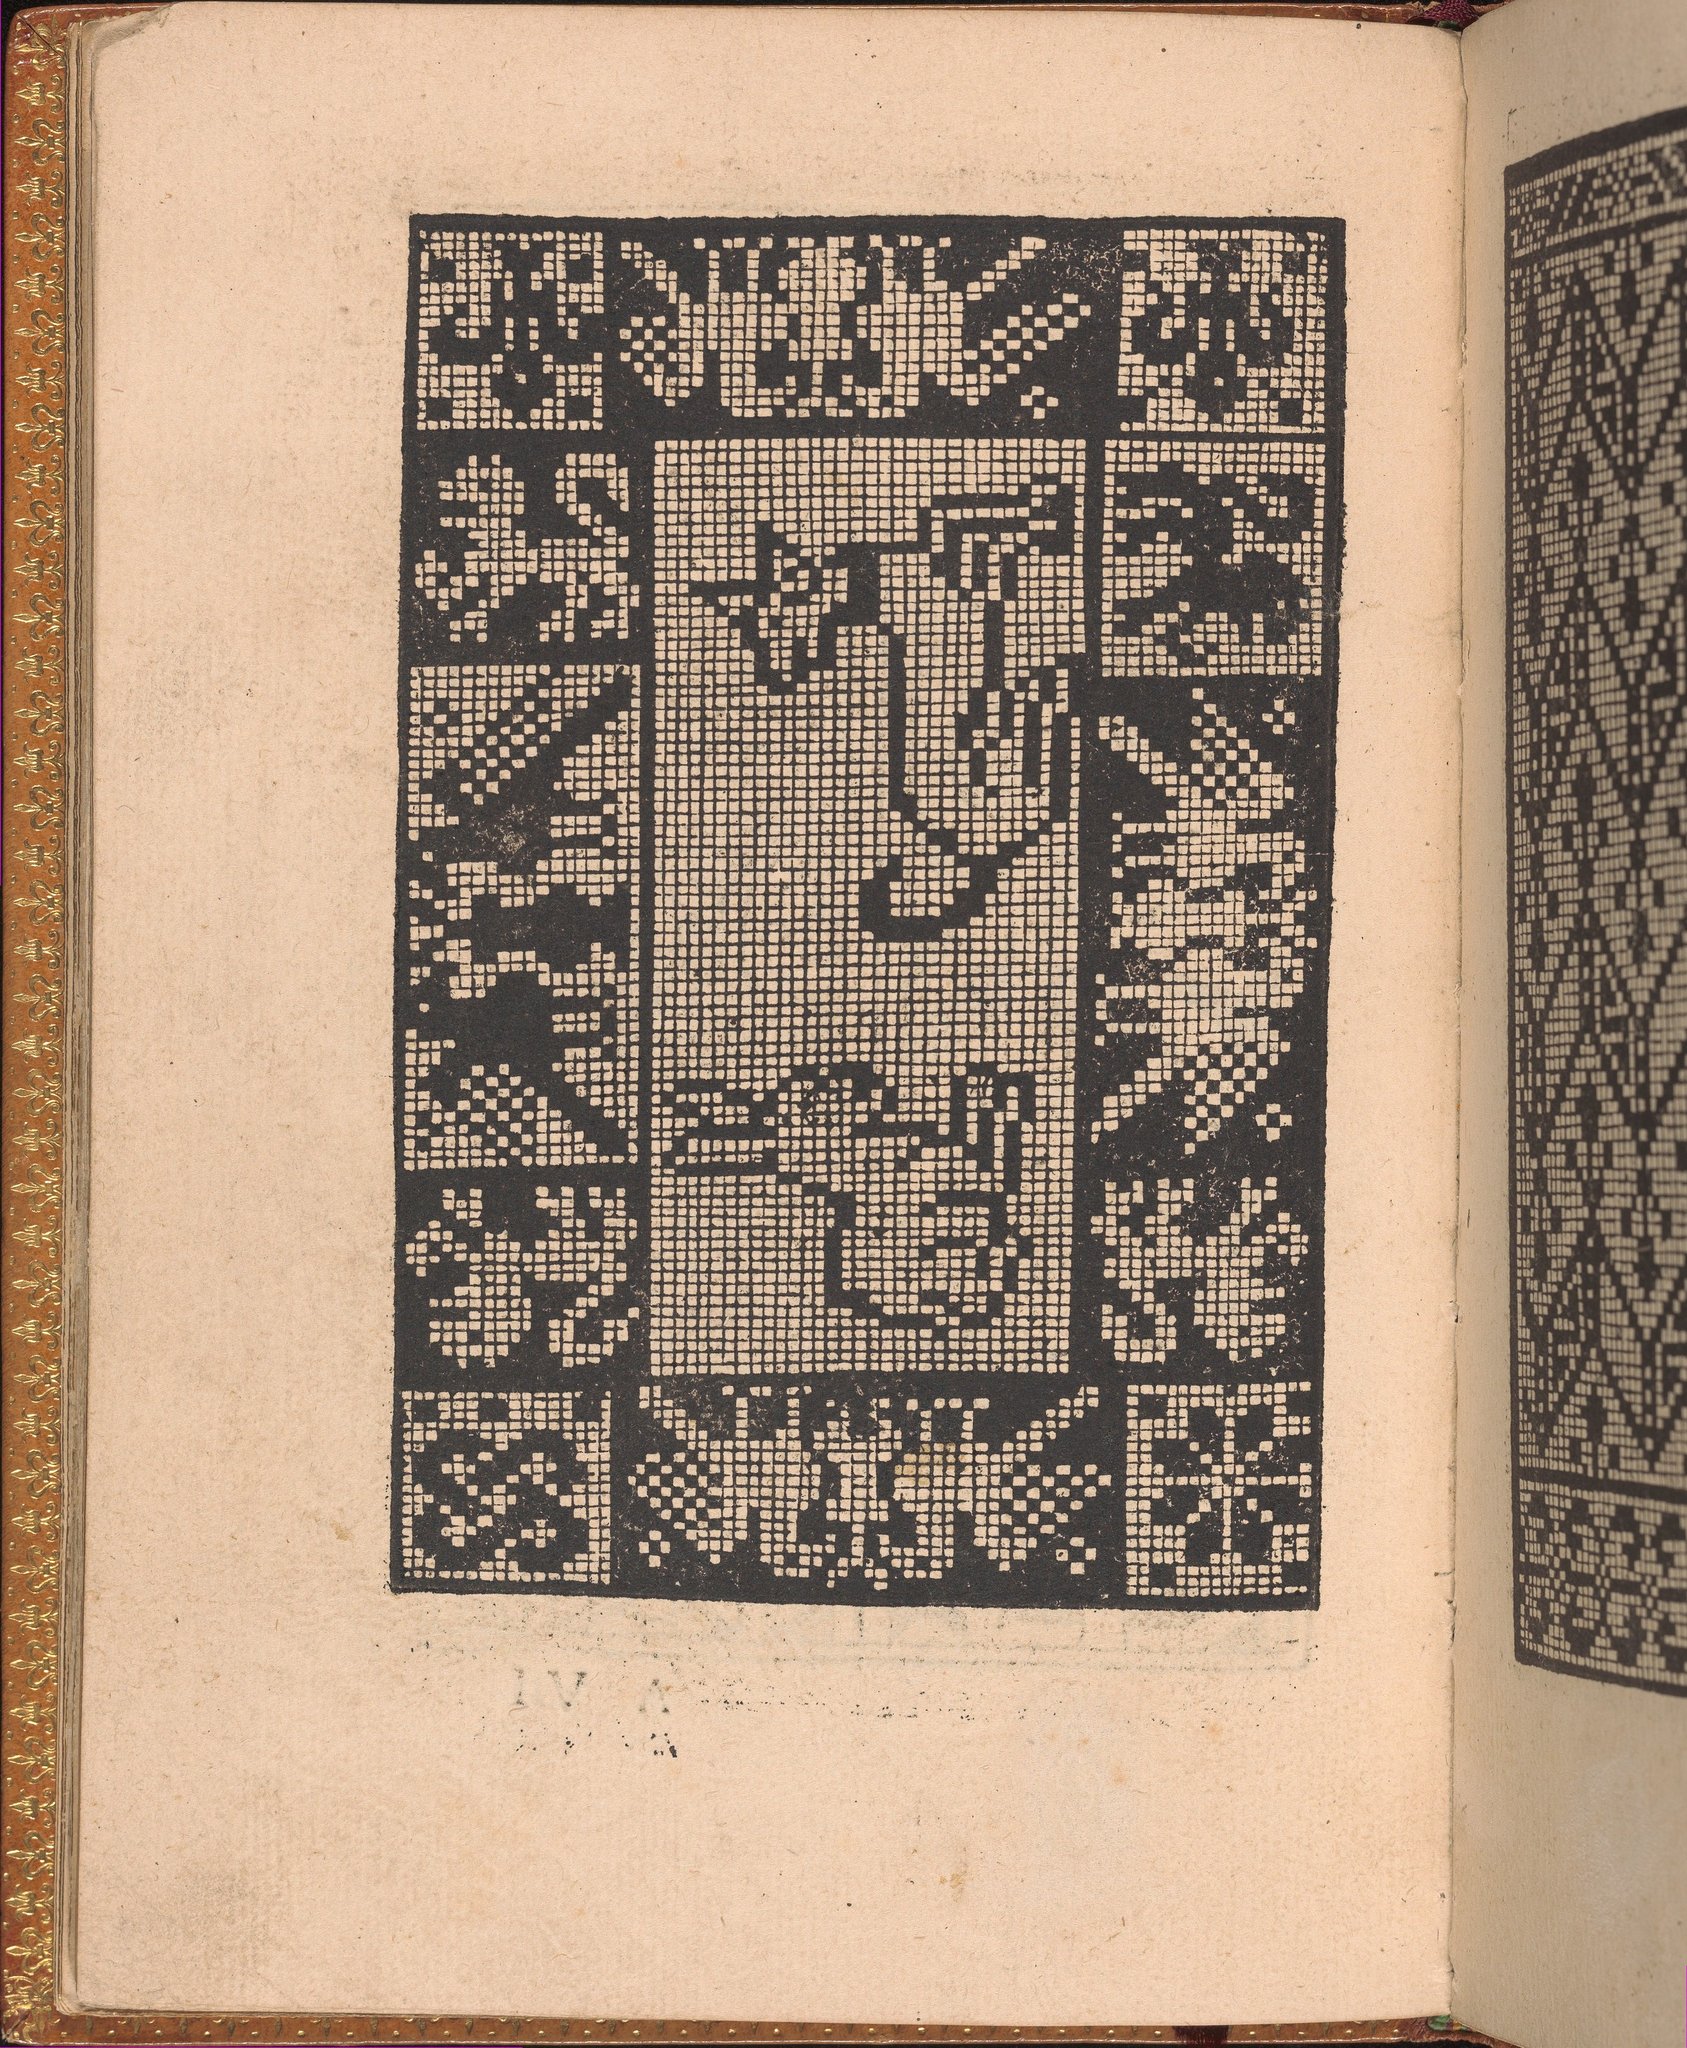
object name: book print ornament architecture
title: Convivio delle Belle Donne, page 8 (verso)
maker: nicolò zoppino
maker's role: publisher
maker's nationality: italian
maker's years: 1478-1544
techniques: woodcut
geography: italy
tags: birds,ornament,dogs,lions,rabbits